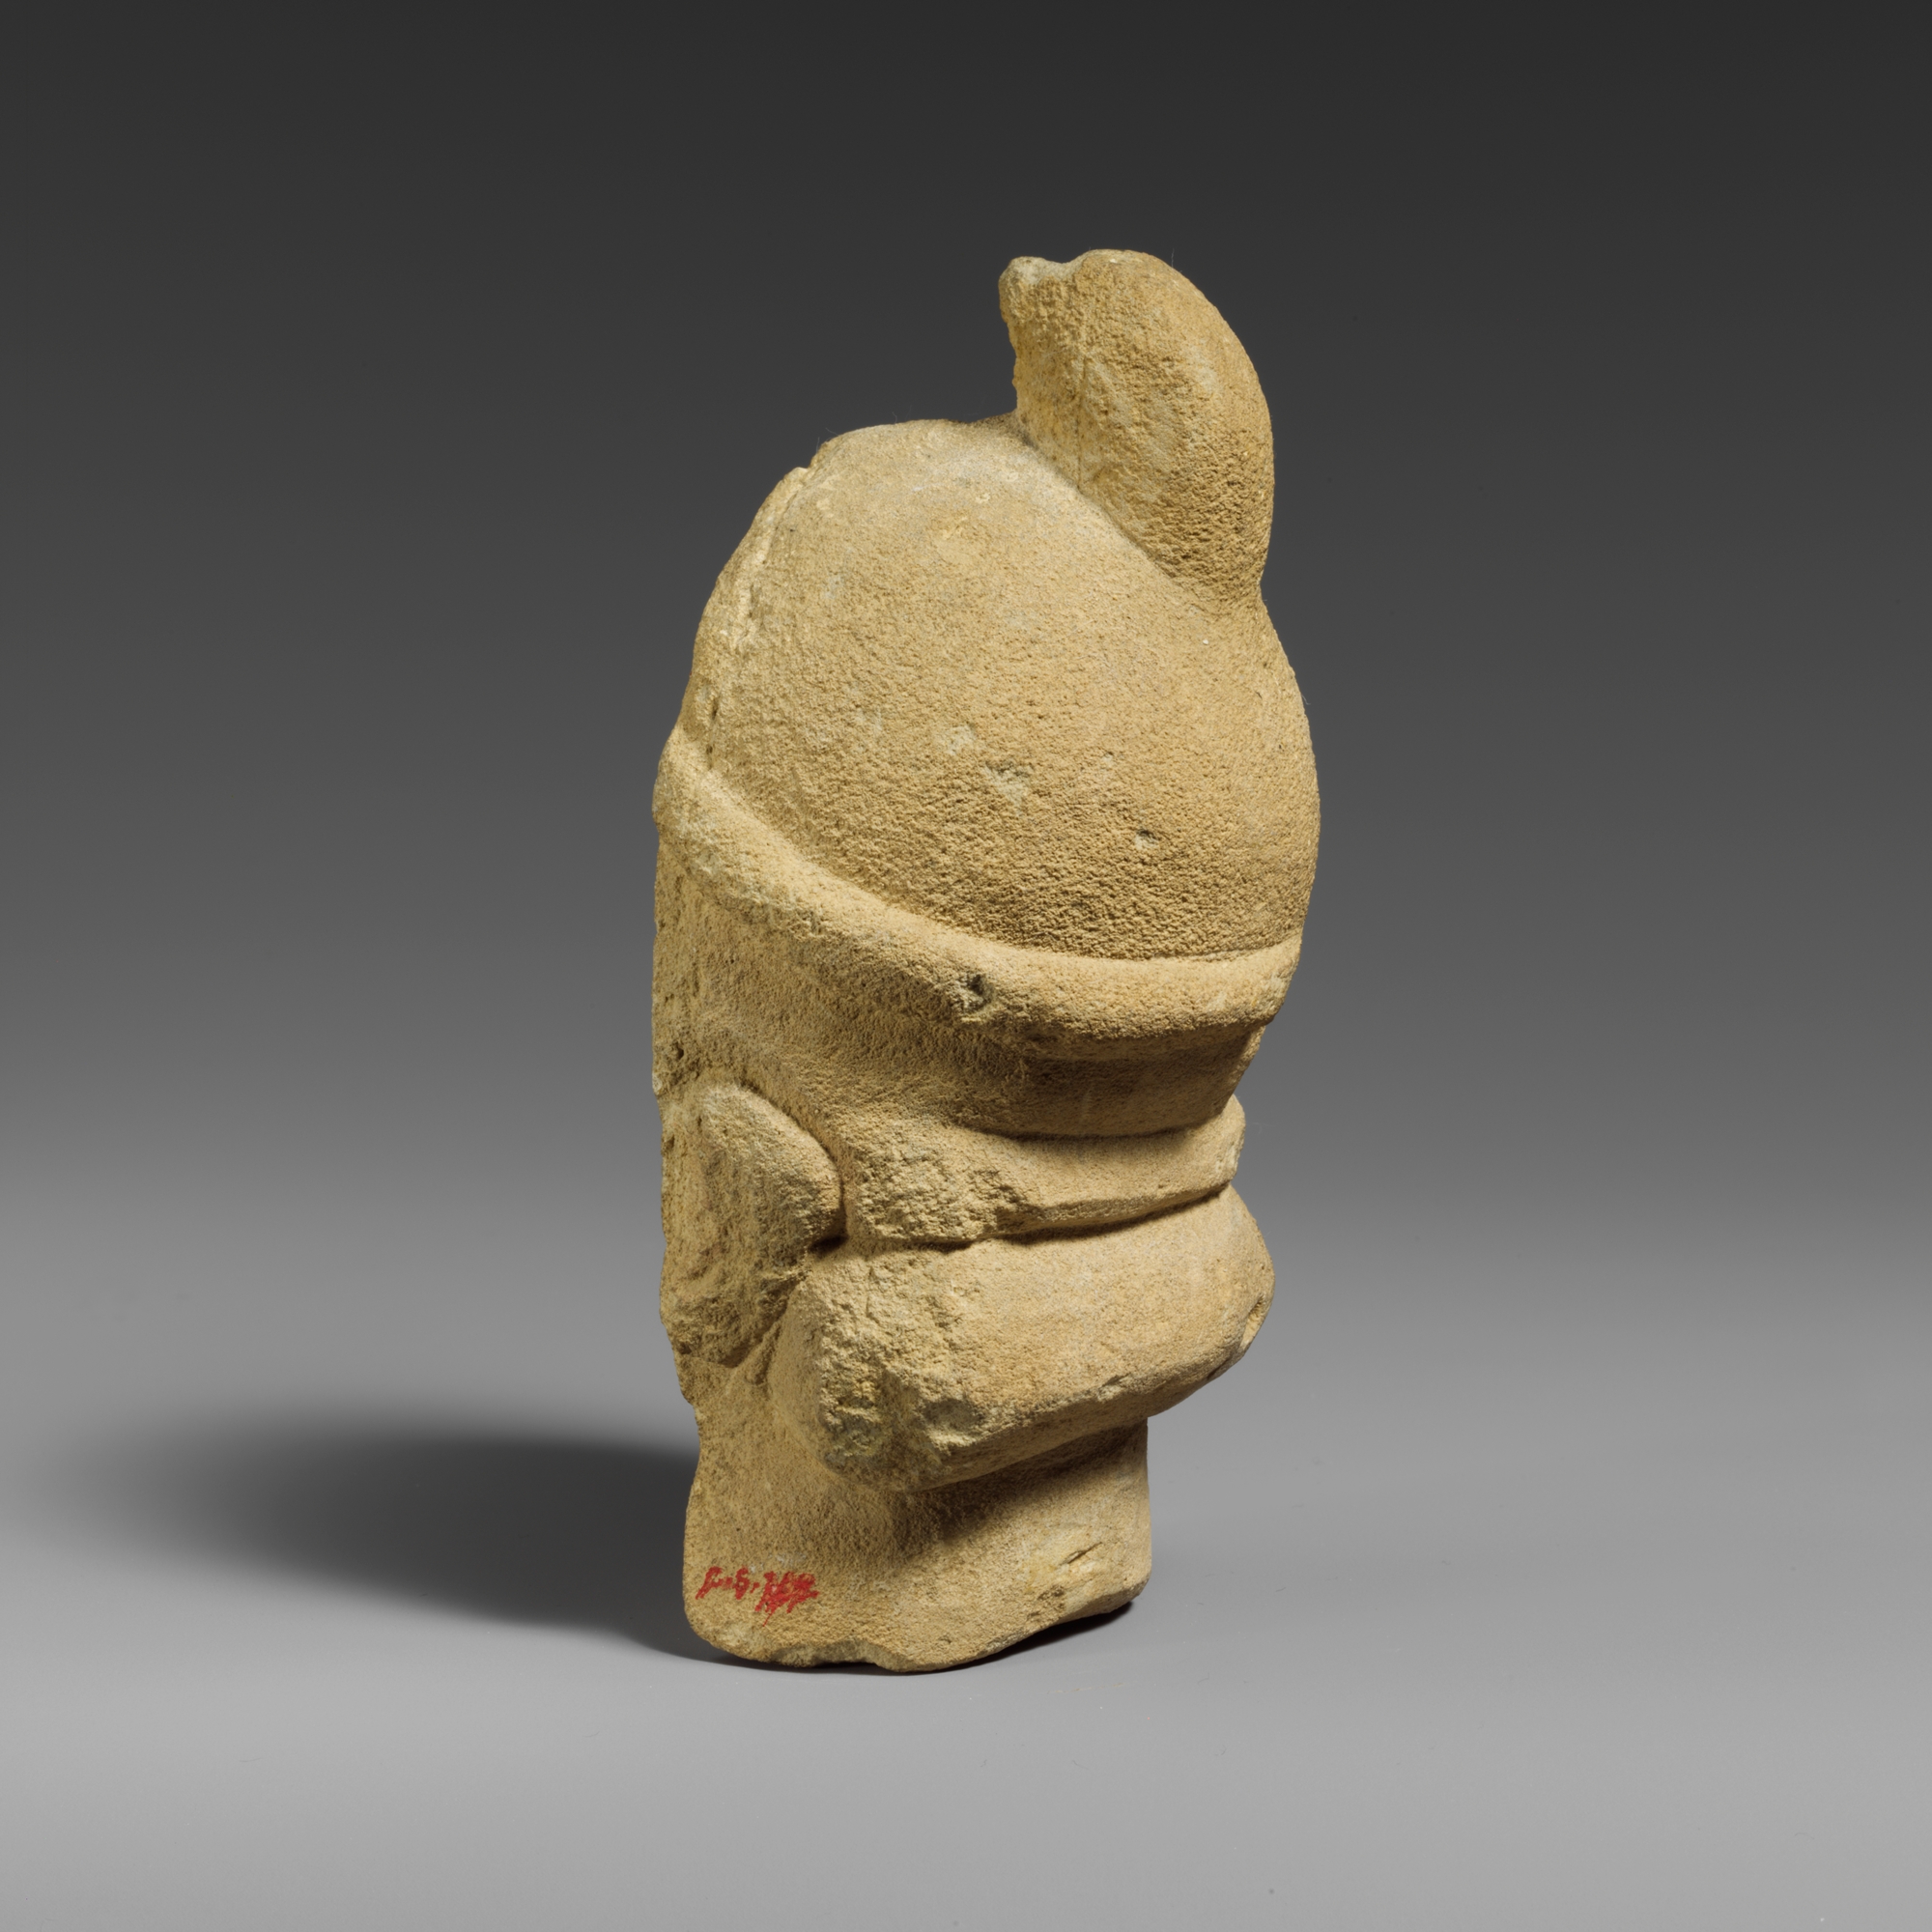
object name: head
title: Fragment of a limestone head of the “Triple Geryon” (?)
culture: cypriot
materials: limestone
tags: helmets,heads